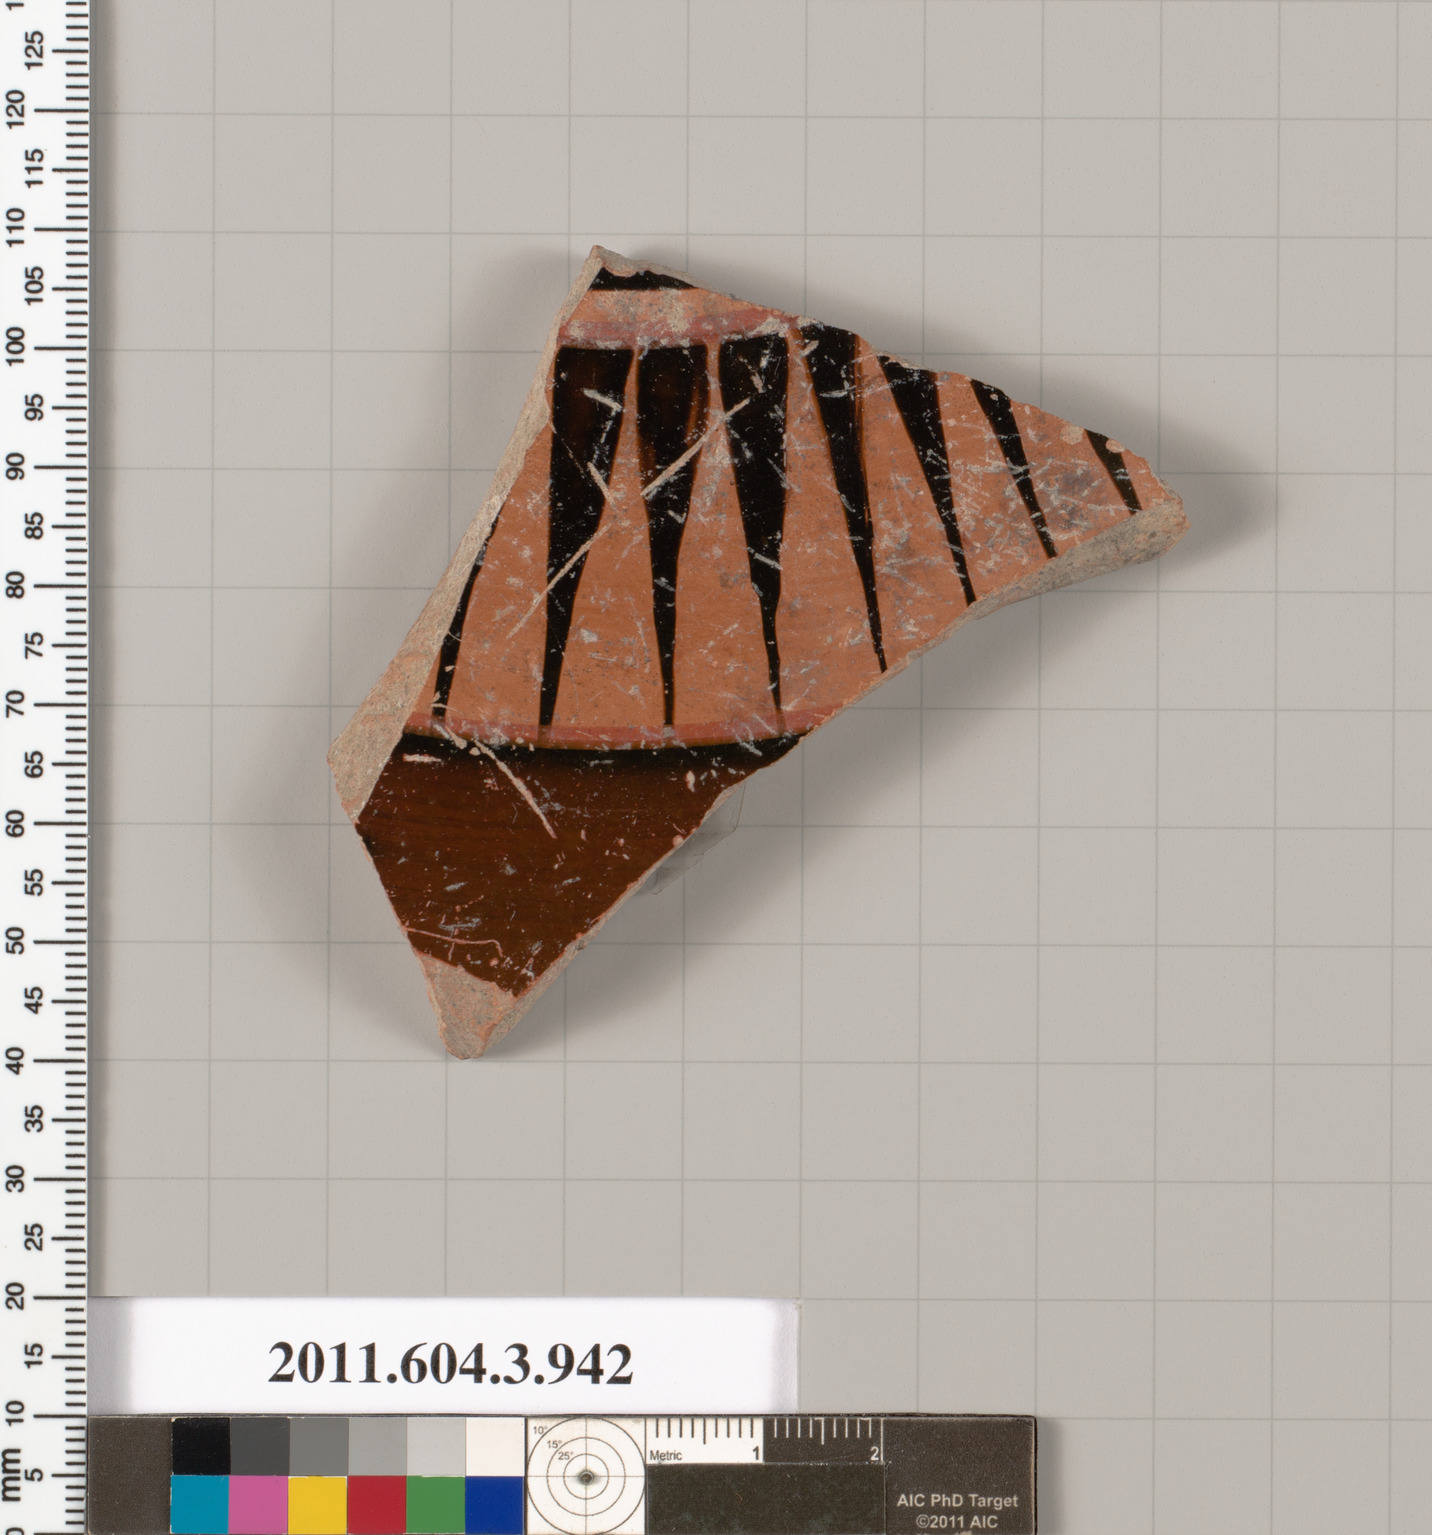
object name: lekanis lid fragment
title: Terracotta fragment of a lekanis lid (covered dish)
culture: greek, attic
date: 600-501 BCE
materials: terracotta